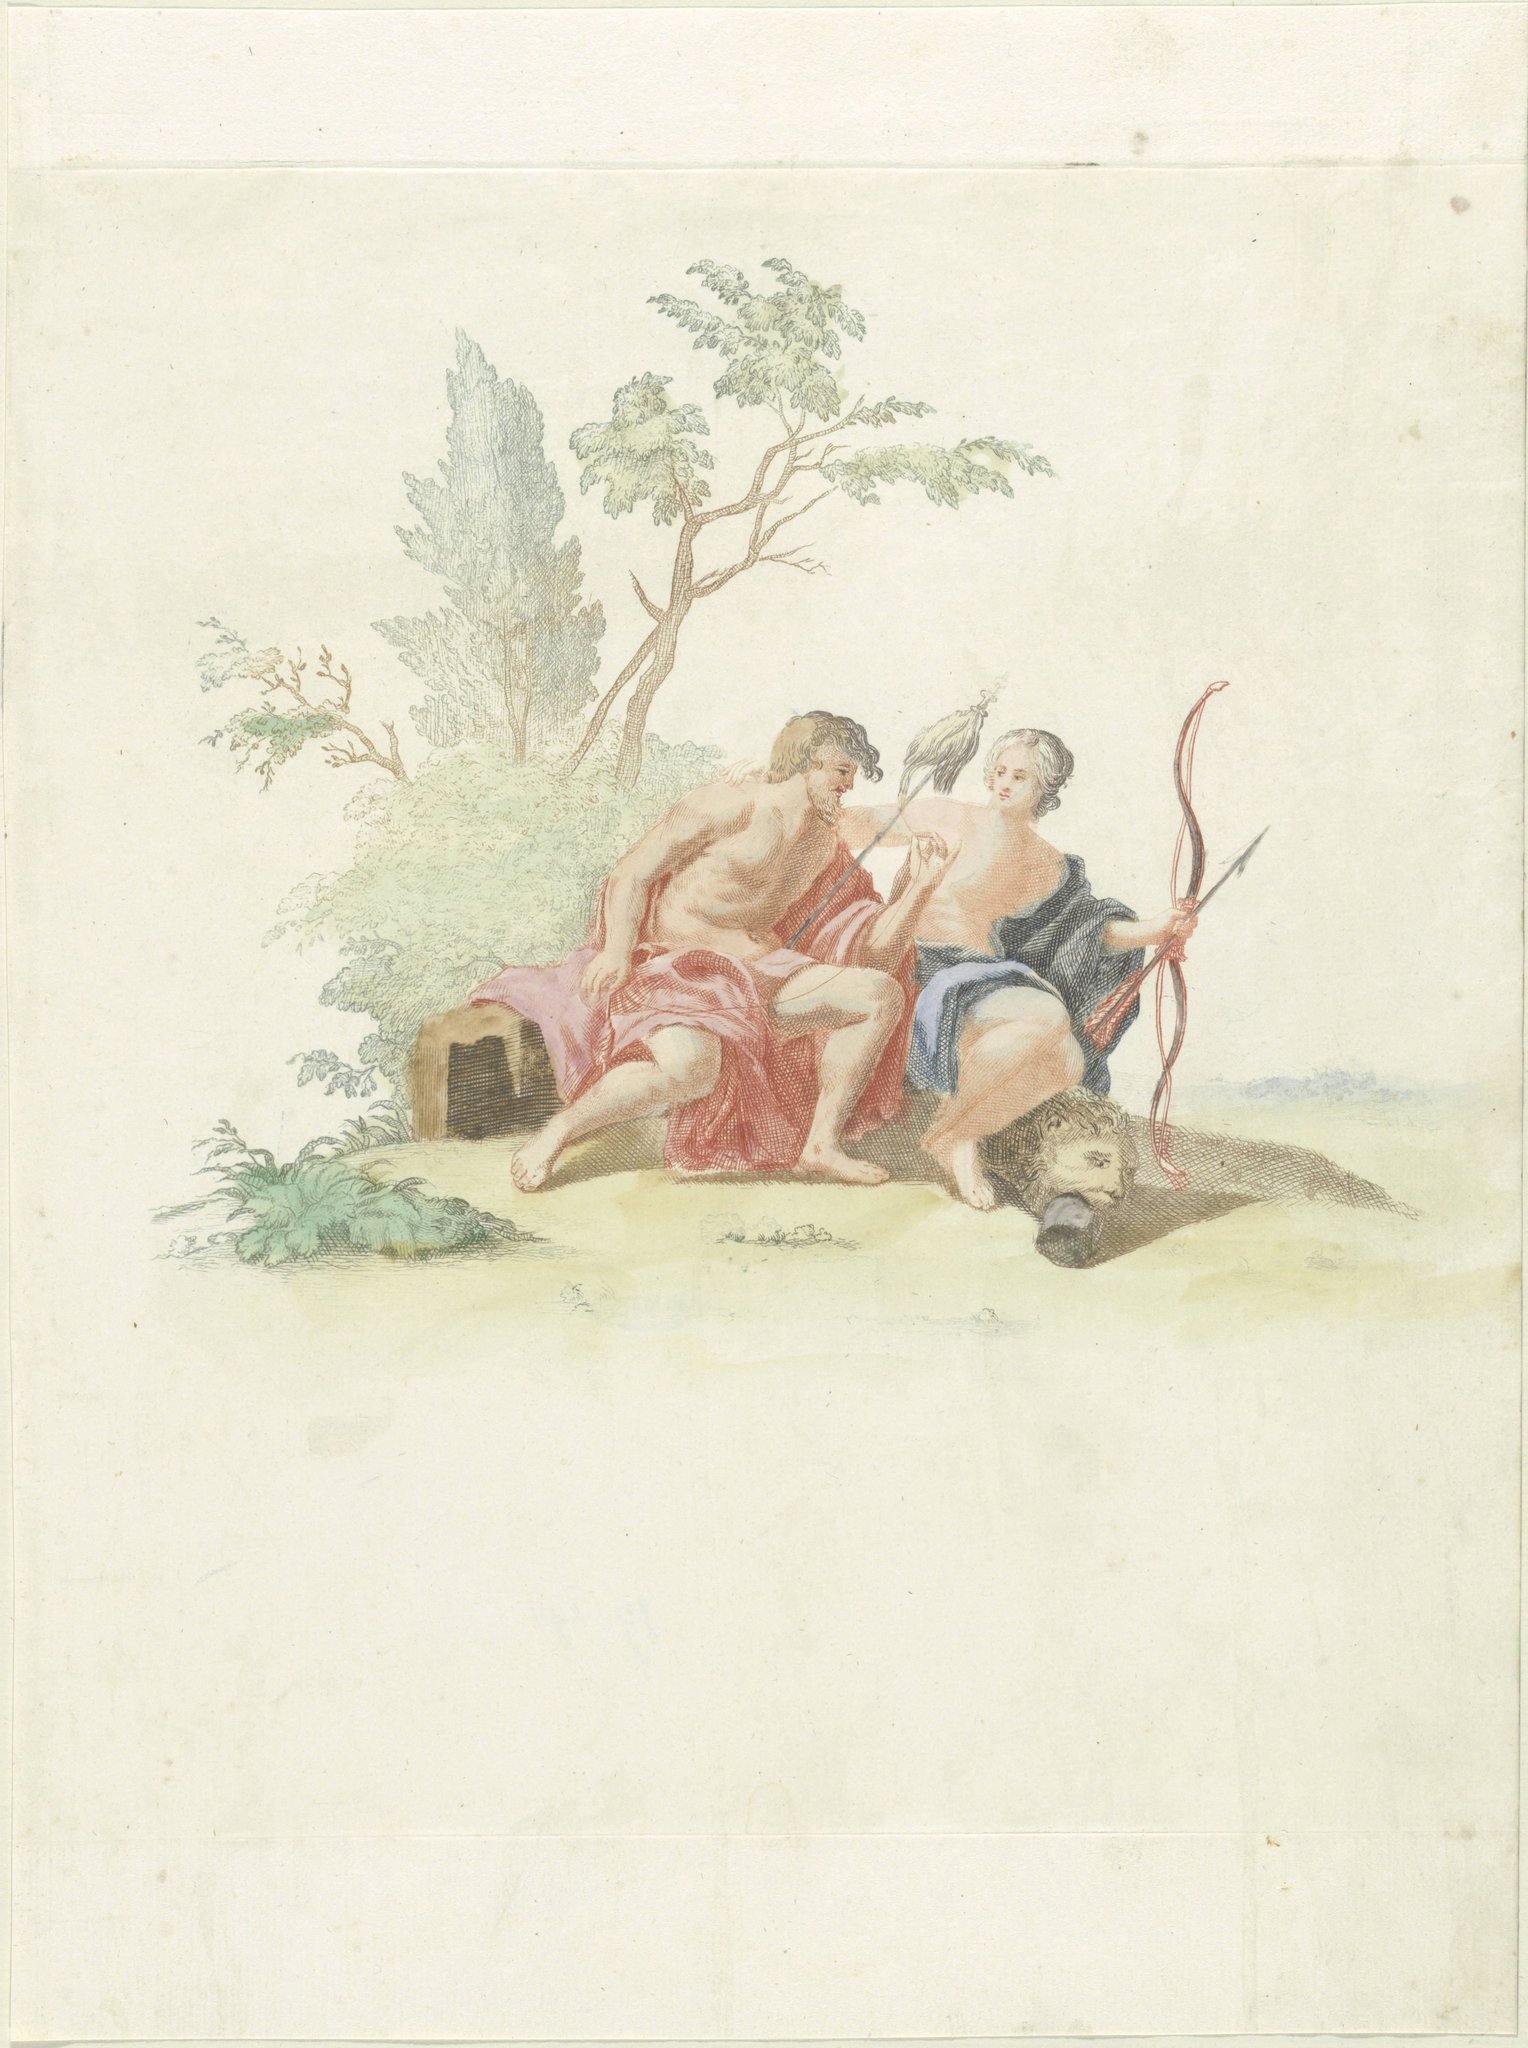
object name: print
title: Hercules en Omphale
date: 1688-1698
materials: paper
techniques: engraving, etching, hand coloring, lithography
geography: netherlands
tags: hercules in love with omphale; the hero is set to spin wool or to do other women's work among the servants, while omphale wears his lion's skin and wields his club and bow, slavery; serfs and enslaved persons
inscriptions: collector's mark: Lugt 2228, collector's mark: Lugt 2760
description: Hercules zit naast Omphale, koningin van Lydië, die een arm om hem heen heeft geslagen. Als slaafgemaakte bediende en minnaar van Omphale werd Hercules ‘vrouwelijk’, hij droeg vrouwenkleren en deed hij ‘vrouwelijke’ dingen als garen spinnen. Hier heeft hij Omphales spinrok in zijn handen. Zij heeft zijn pijl en boog en de leeuwenhuid en knots liggen aan haar voeten.